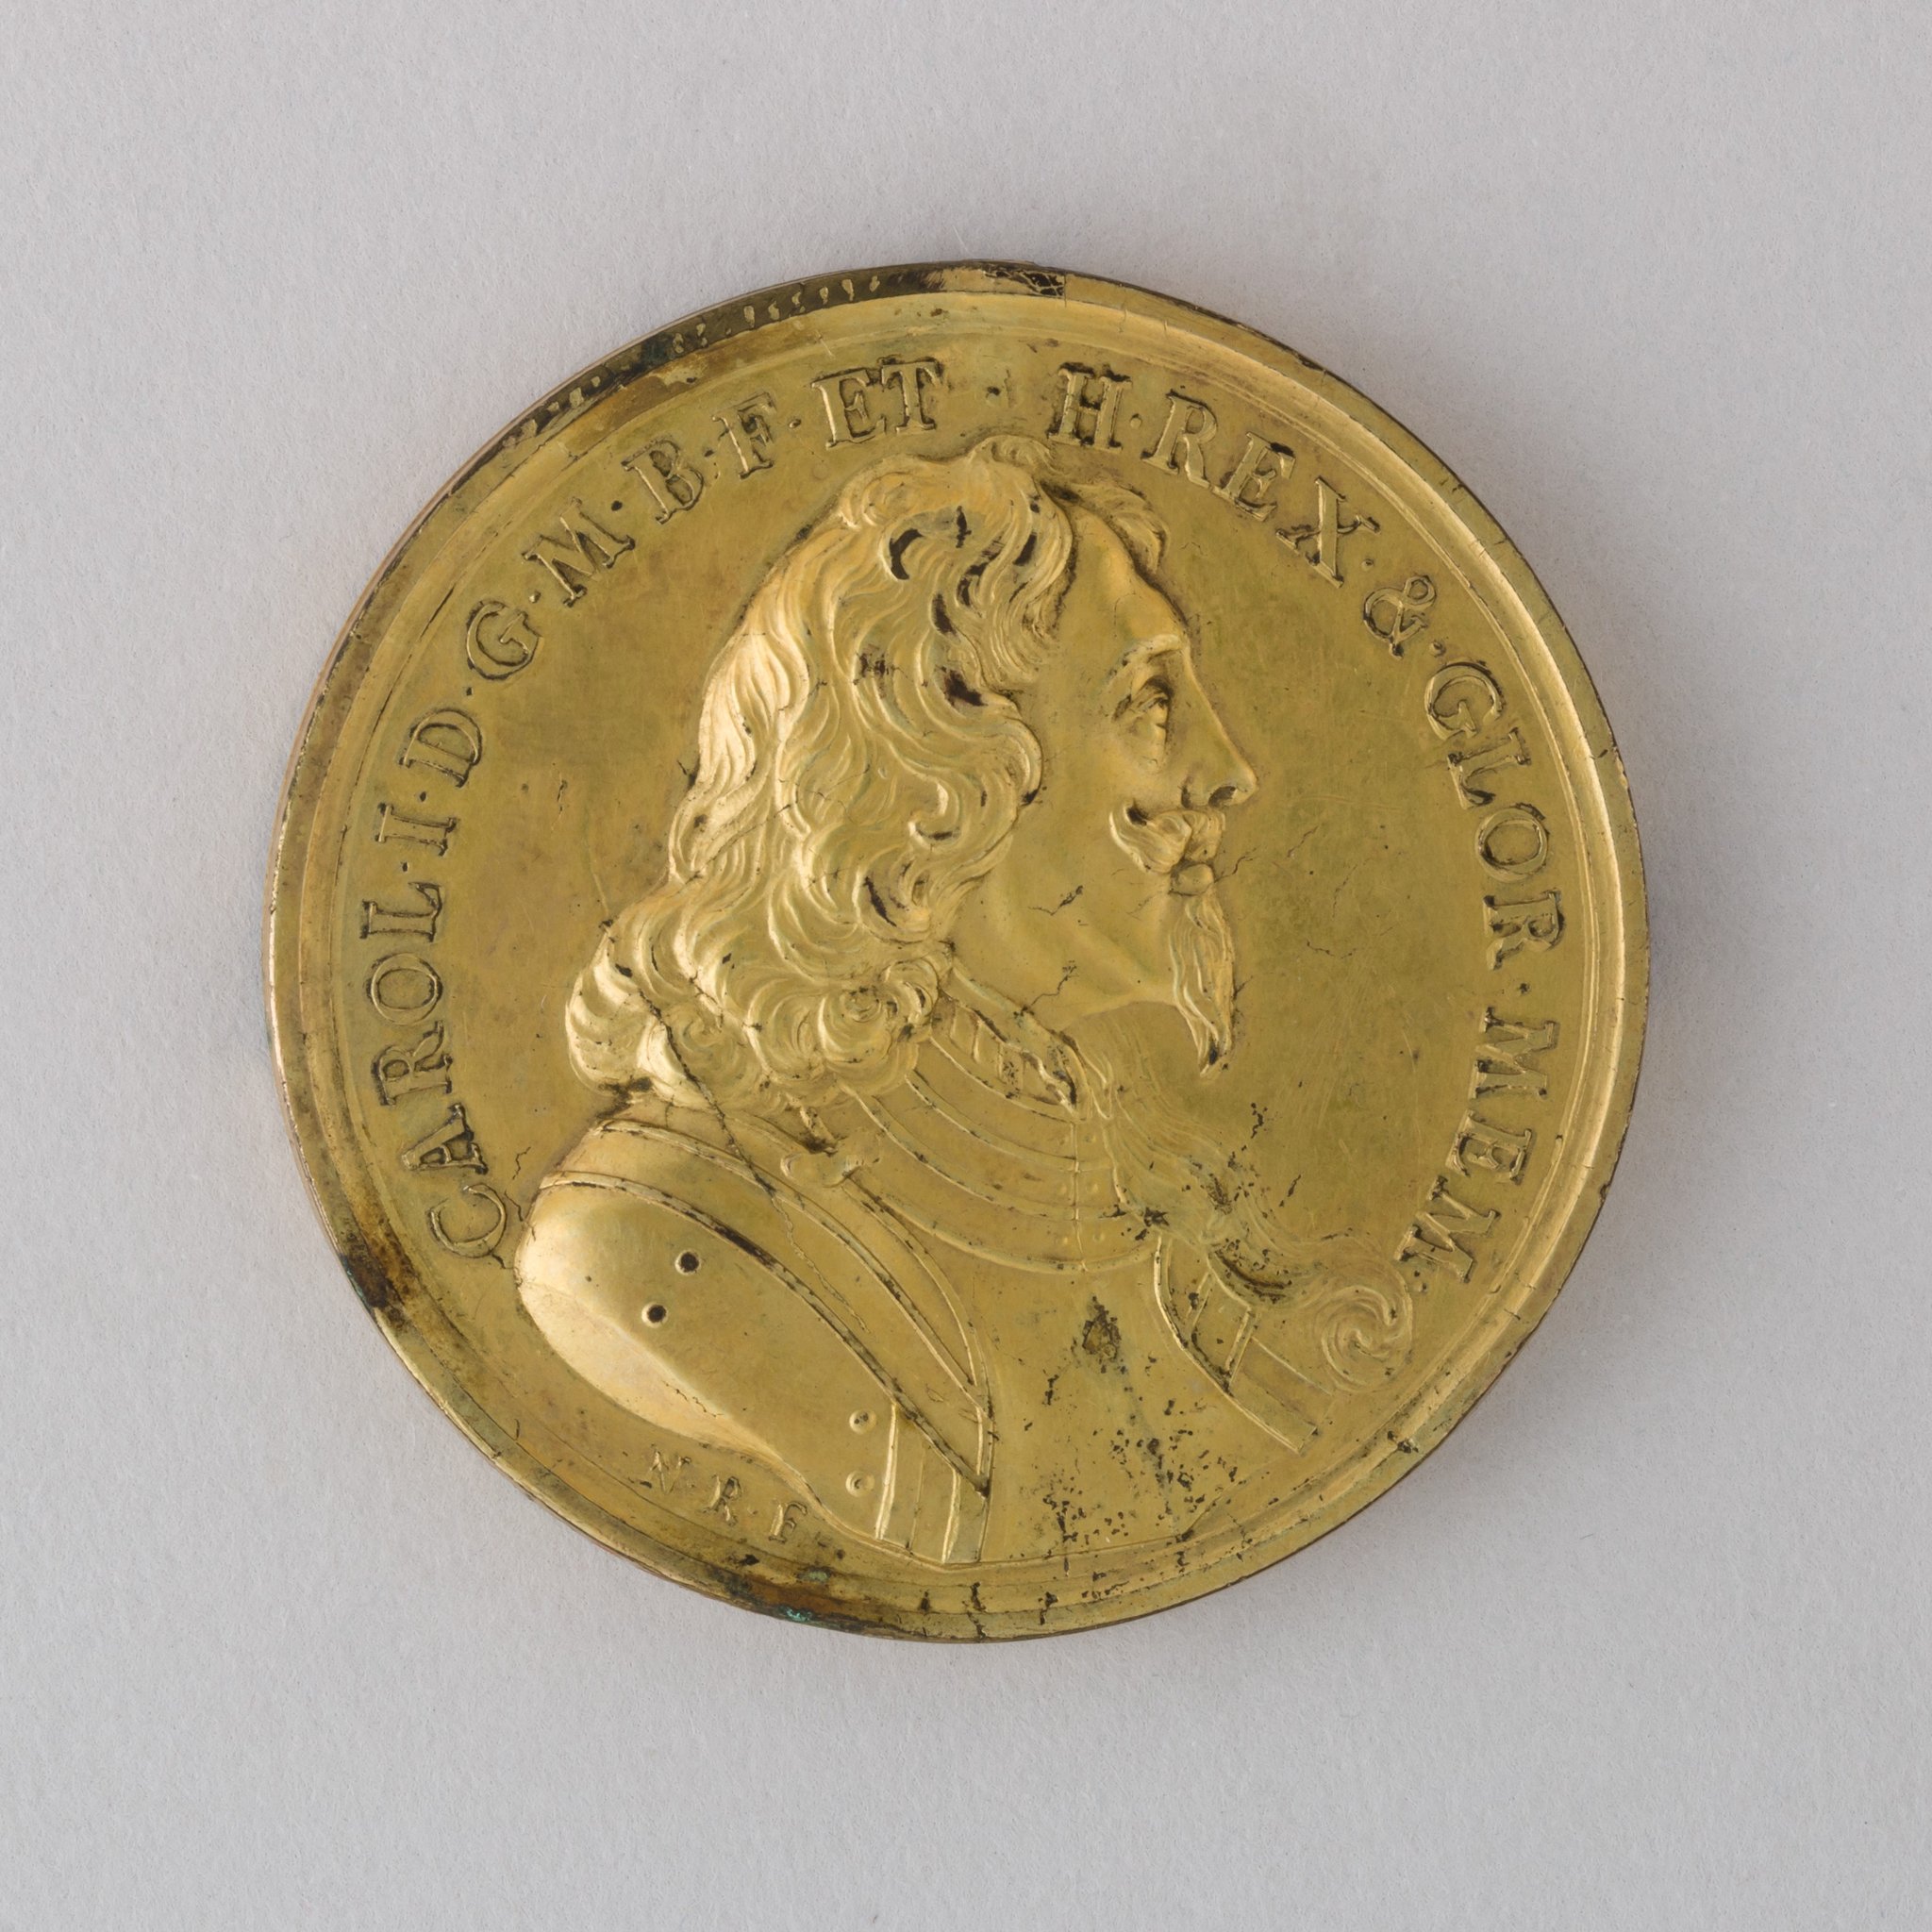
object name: medal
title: Memorial Medal for Charles I, 1649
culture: british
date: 1667-1700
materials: gold, silver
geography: england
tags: men,profiles